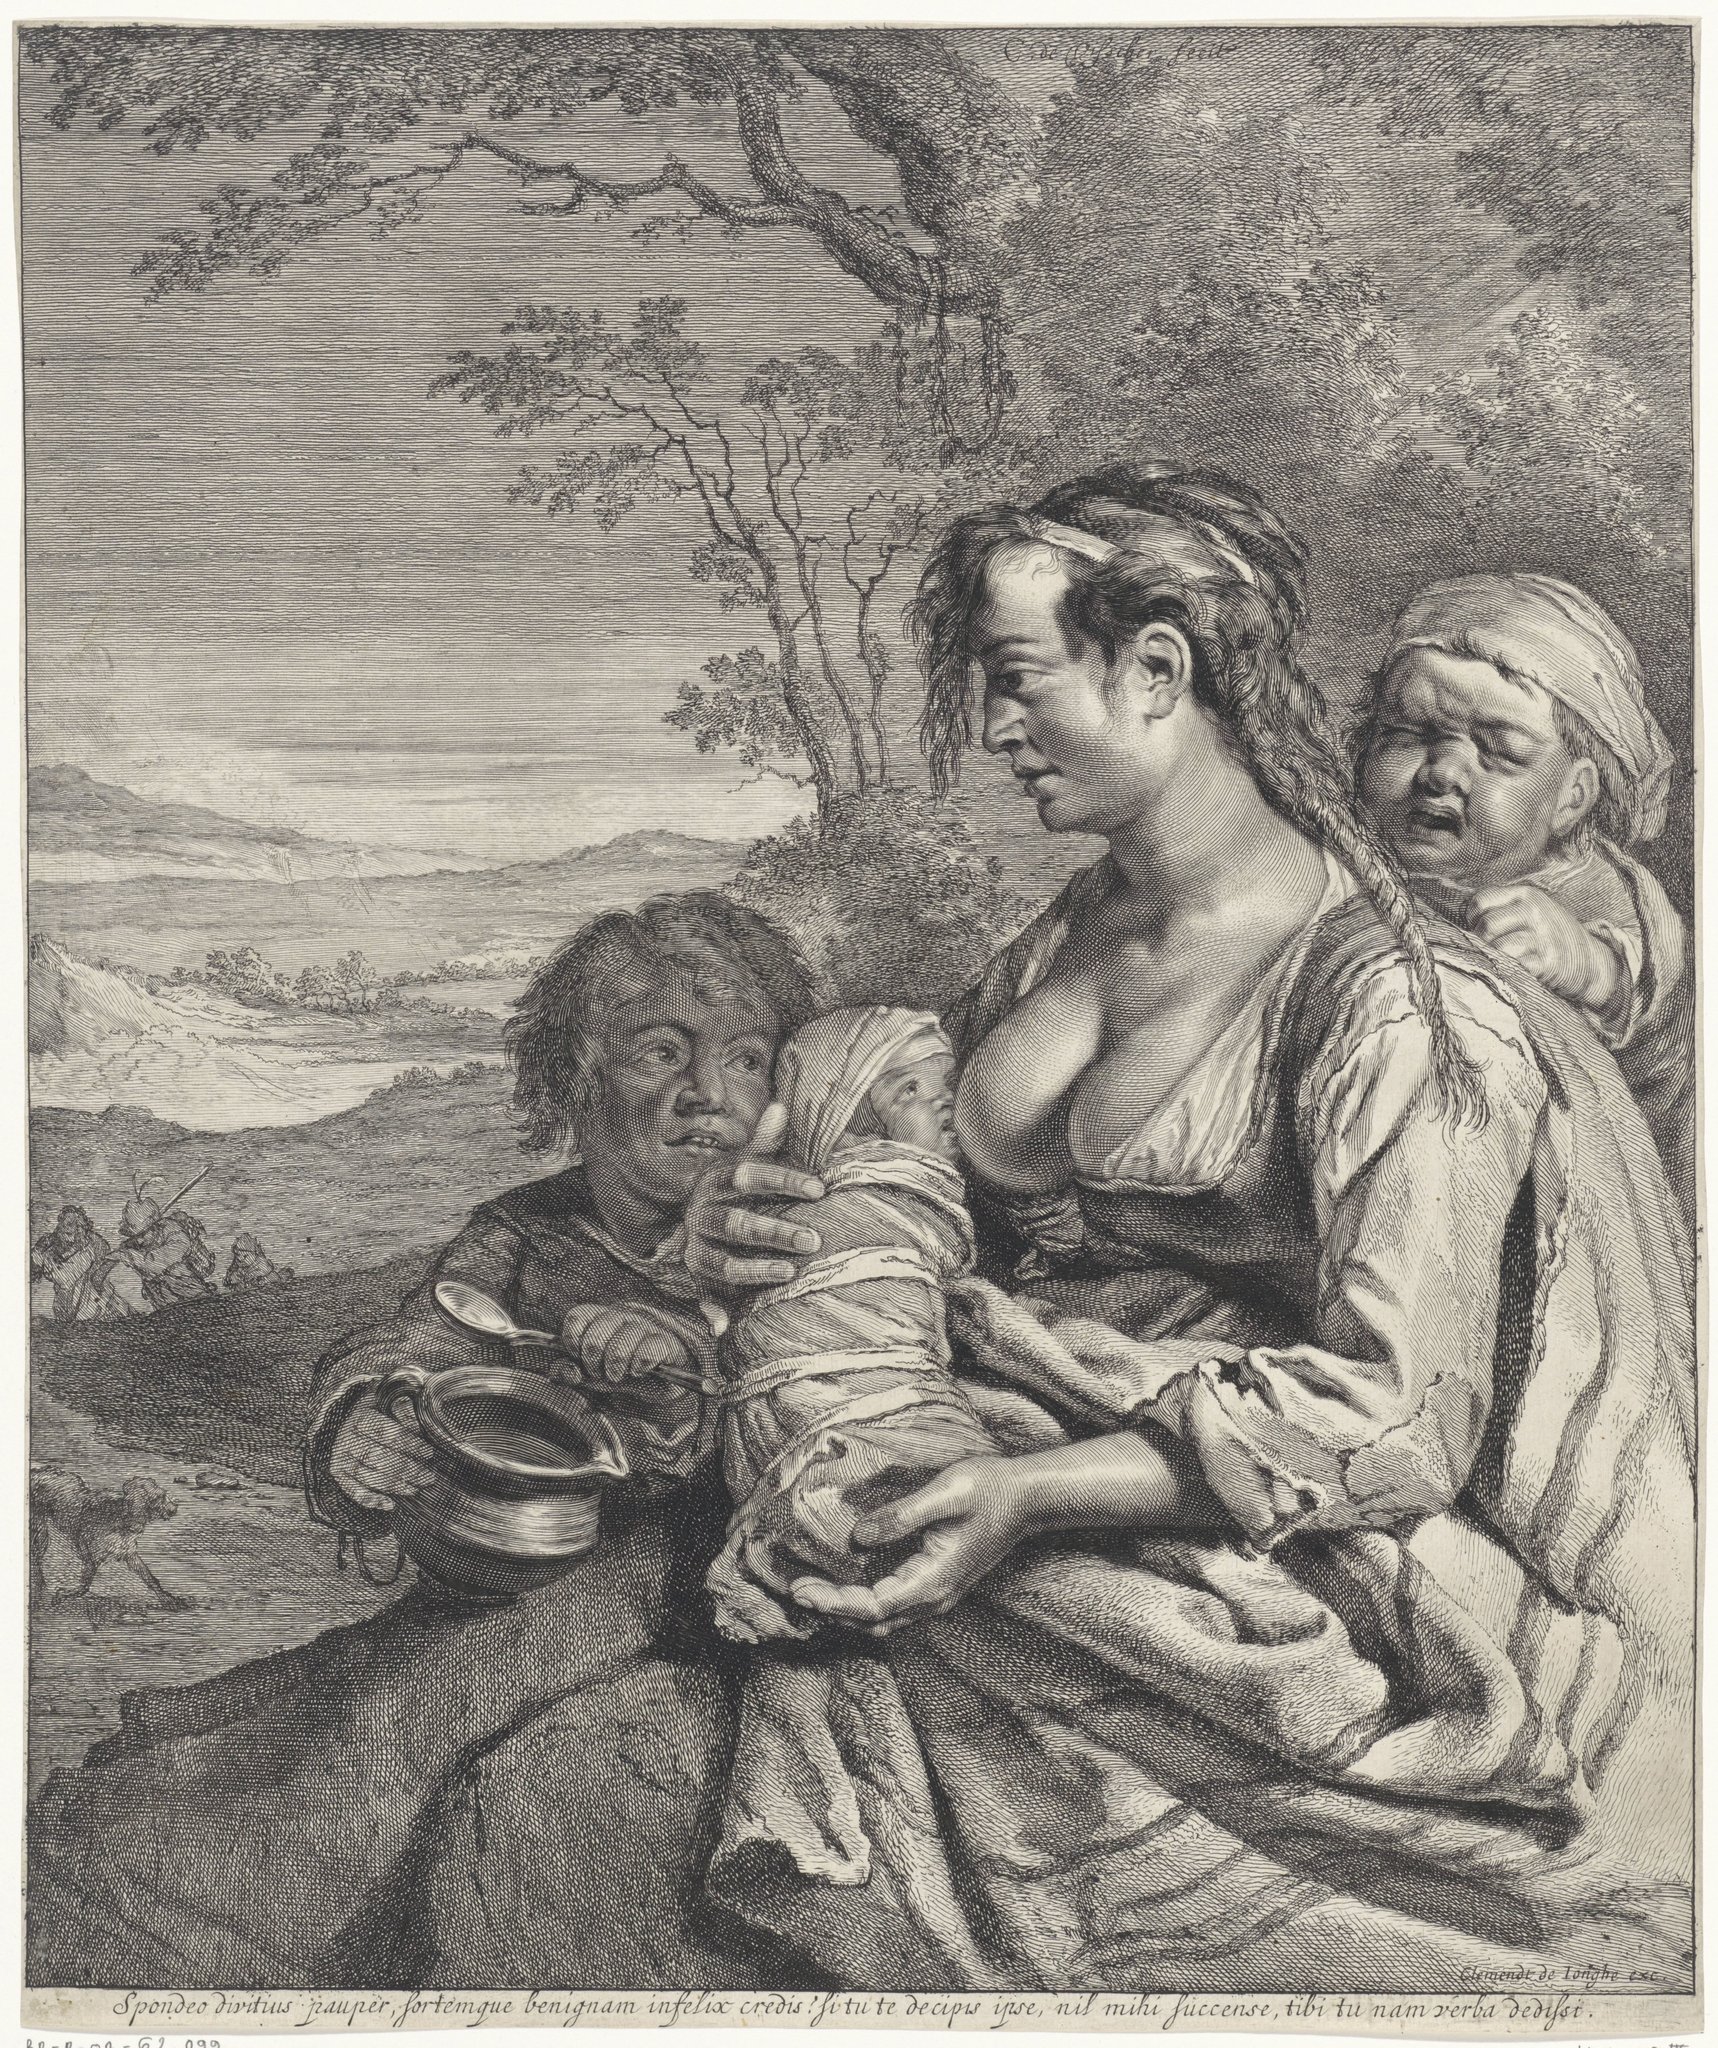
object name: print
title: Roma vrouw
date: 1638-1670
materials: paper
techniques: engraving, etching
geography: amsterdam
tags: nursing, suckling, wandering communities: romani or roma, weeping, 'en route', traveller under way, dog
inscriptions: collector's mark: Lugt 240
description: In een heuvelachtig landschap geeft een Roma vrouw haar baby de borst. Naast haar staat een jong kind met een nap en een lepel. Op haar rug een derde kind dat huilt. Op de achtergrond drie reizigers en een hond. ‘Heidens’ of ‘heidenen’ was een eigentijdse benaming voor Roma.